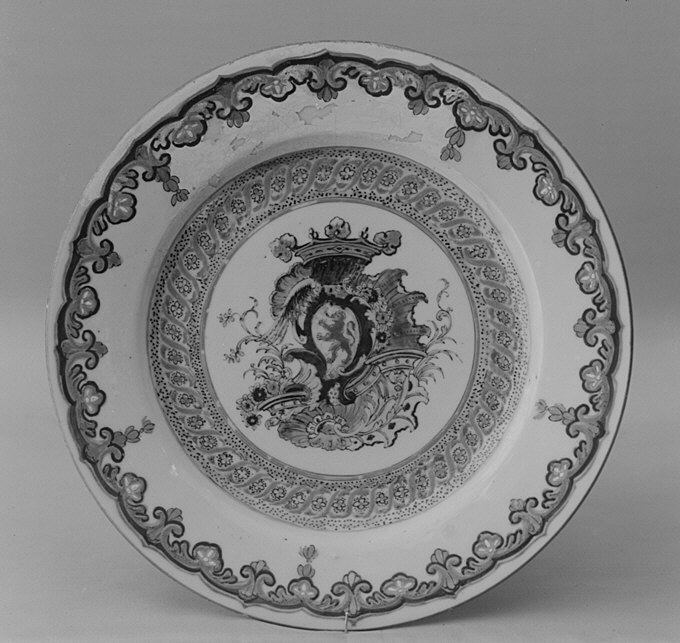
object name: plate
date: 1774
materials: hard paste porcelain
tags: coat of arms